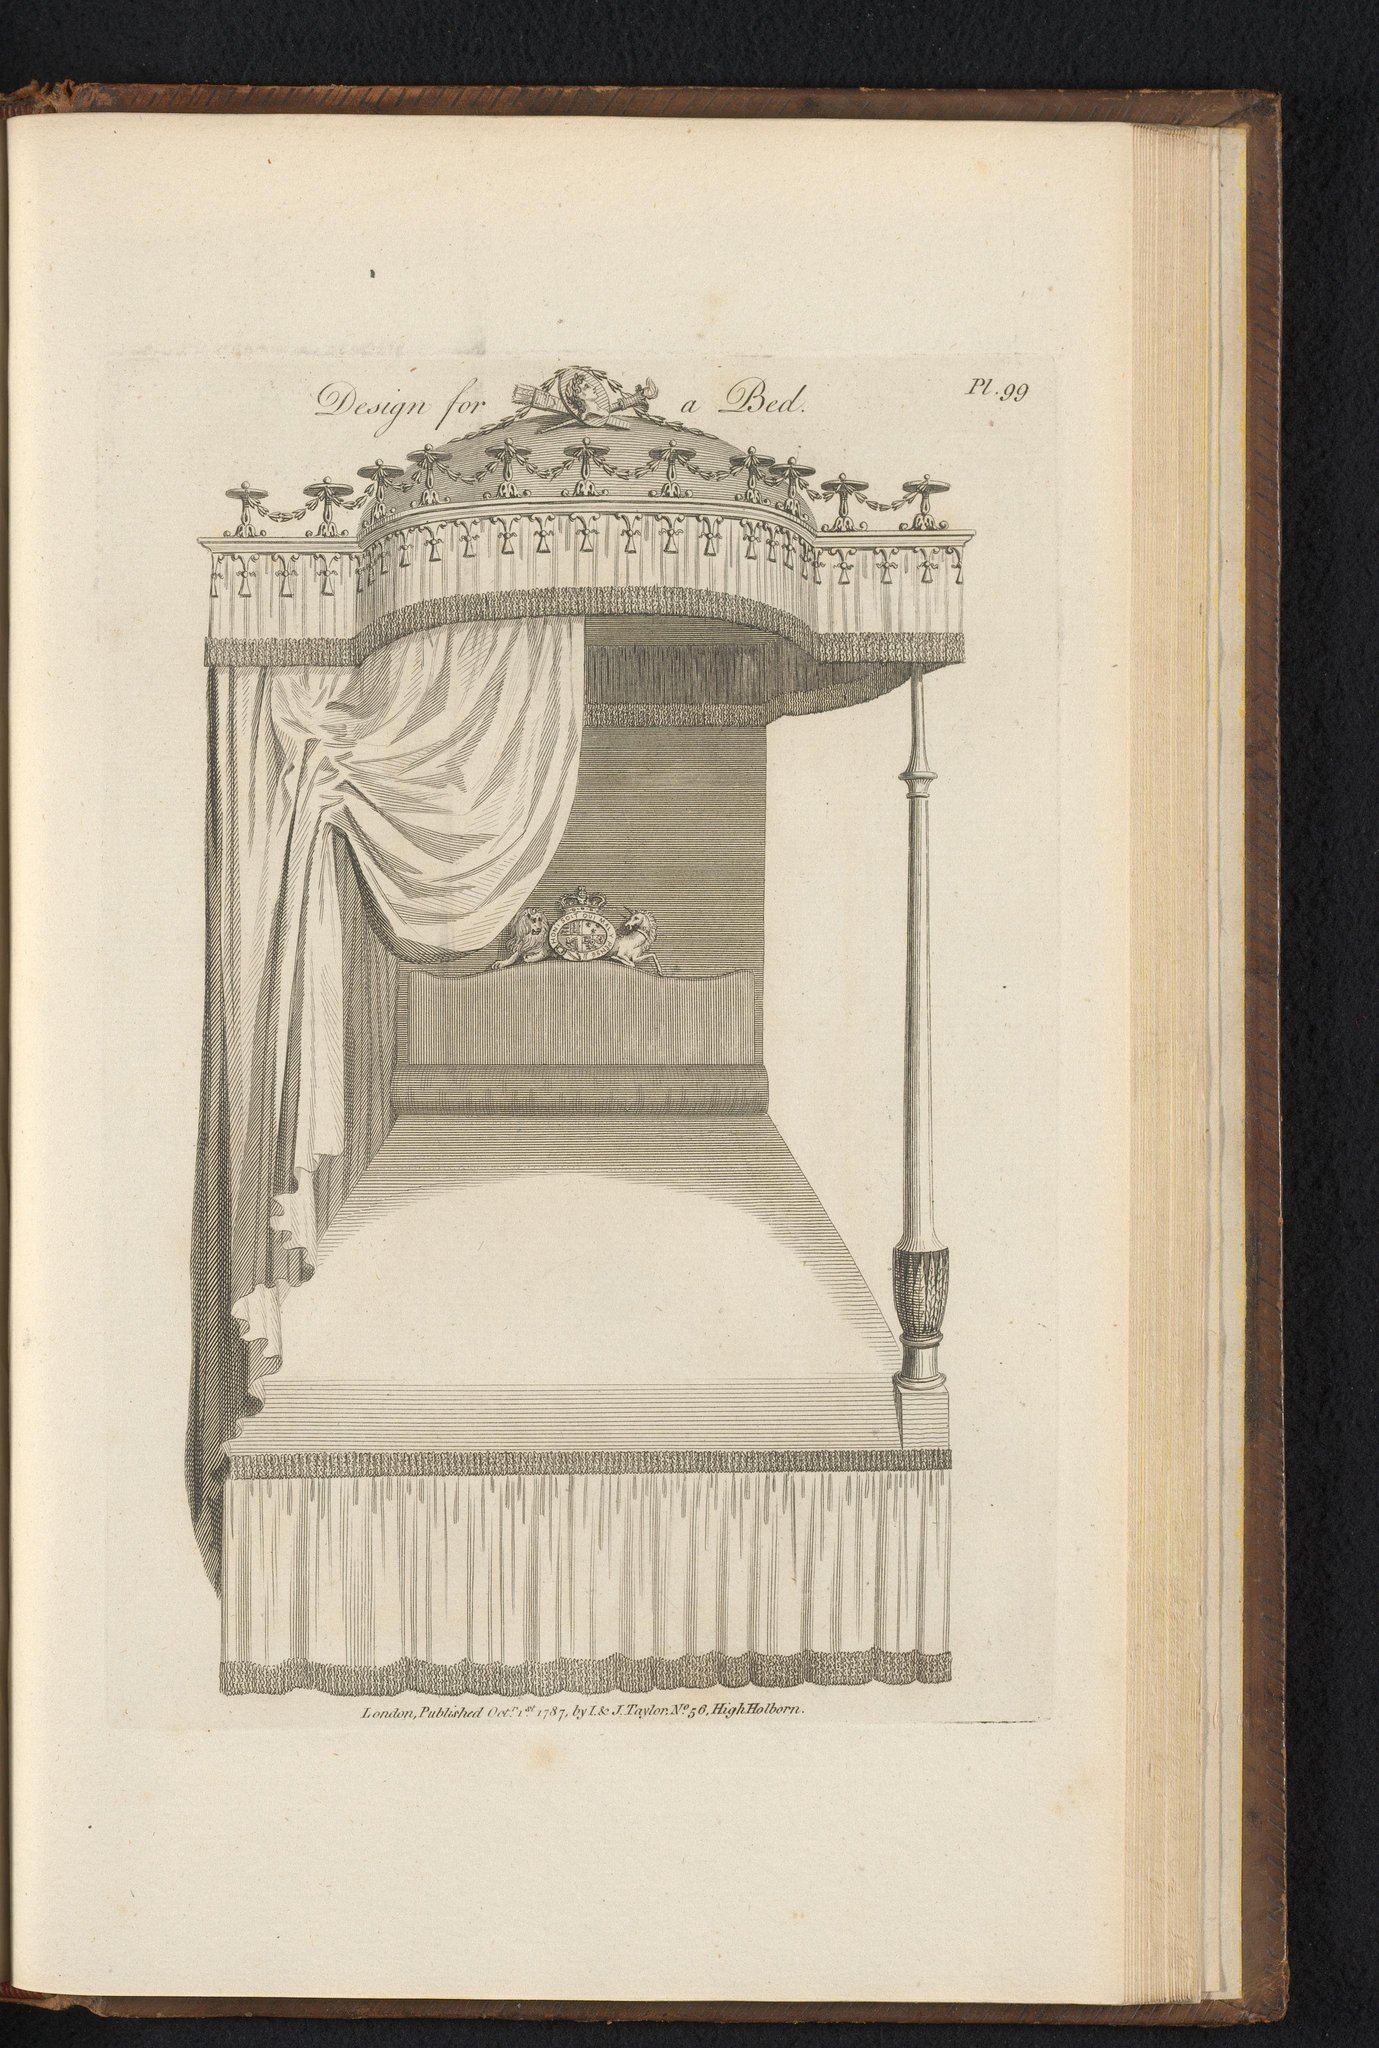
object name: page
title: Meubels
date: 1787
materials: paper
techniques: engraving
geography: holborn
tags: bed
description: Genummerd: Pl. 99. Bed gemerkt: A. Prent maakt deel uit van een boek.